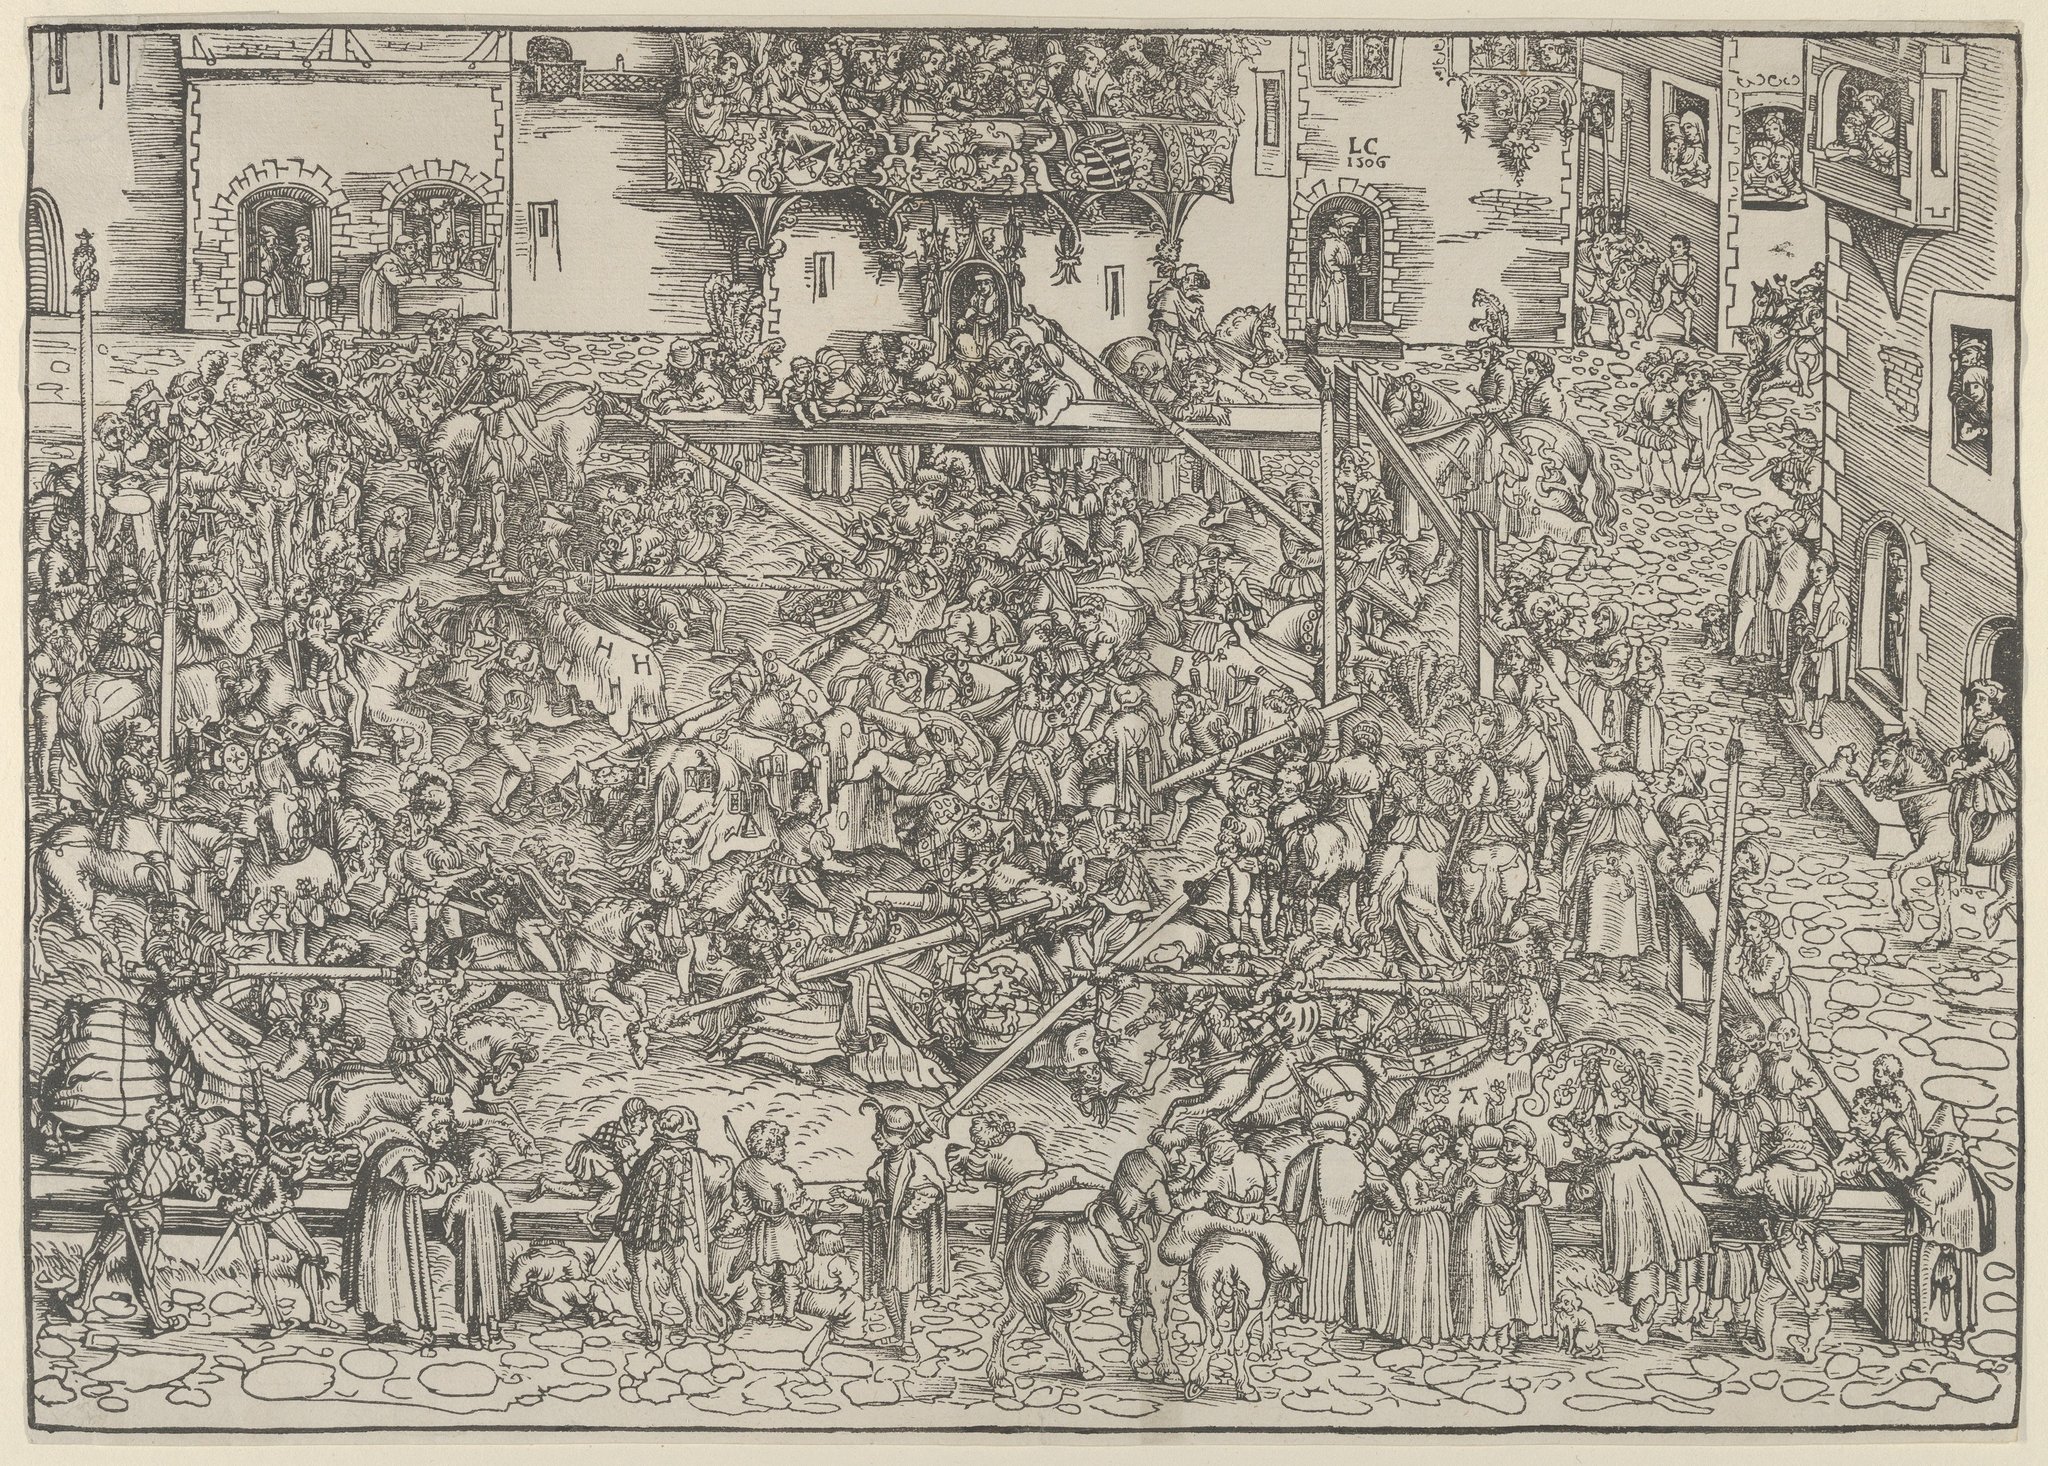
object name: print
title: The First Tournament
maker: lucas cranach the elder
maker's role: artist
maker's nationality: german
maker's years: 1472-1553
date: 1506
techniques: woodcut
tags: buildings,men,spectators,horses